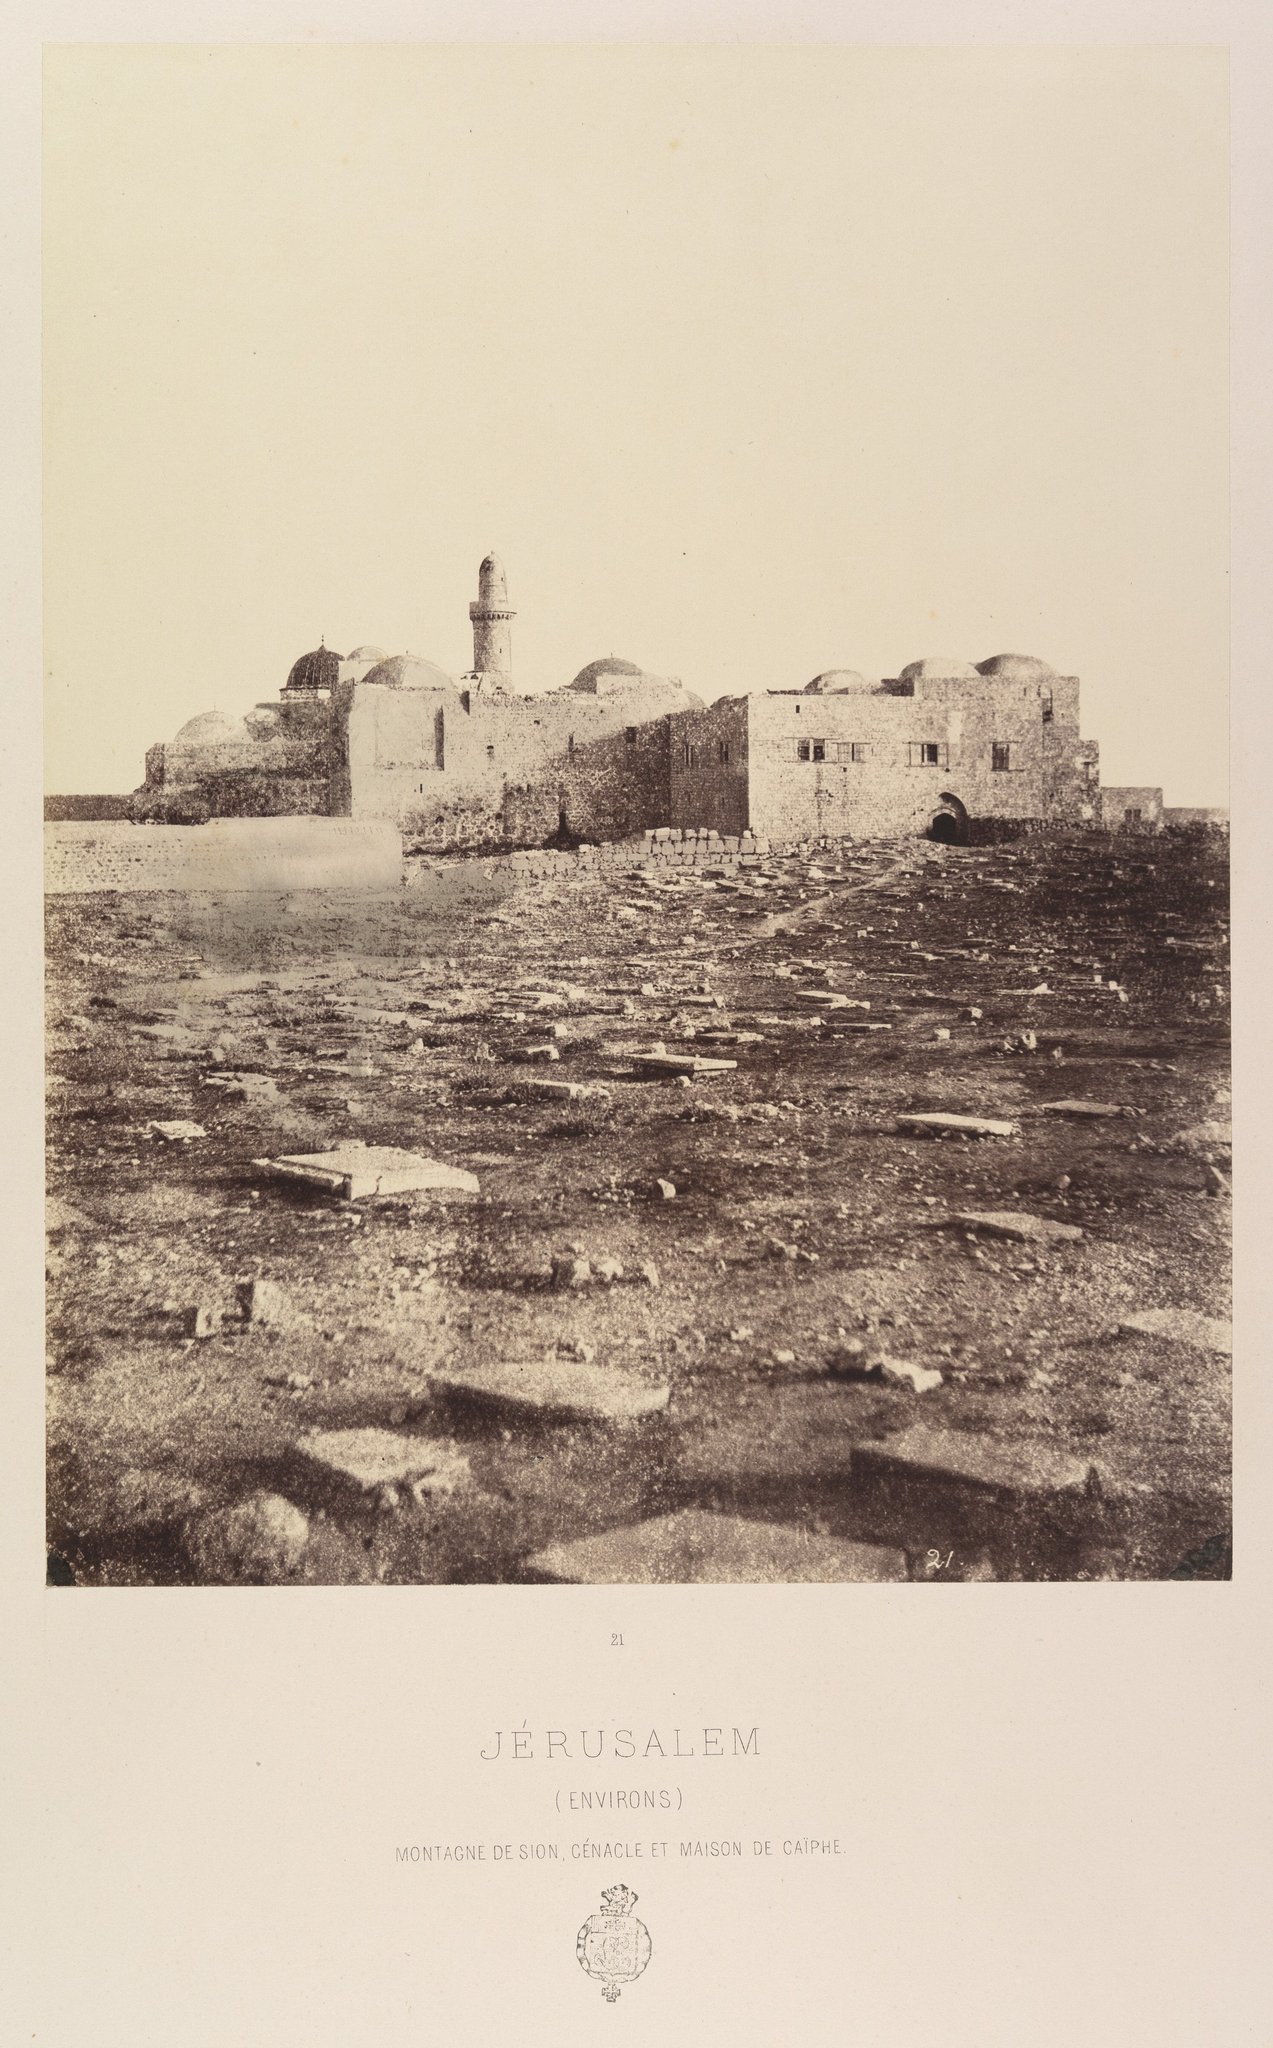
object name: photograph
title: Jérusalem. (Environs) Montagne de Sion. Cenacle et Maison de Caiphe.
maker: louis de clercq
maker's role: artist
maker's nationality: french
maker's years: 1837-1901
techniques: albumen silver print, paper negative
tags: architecture